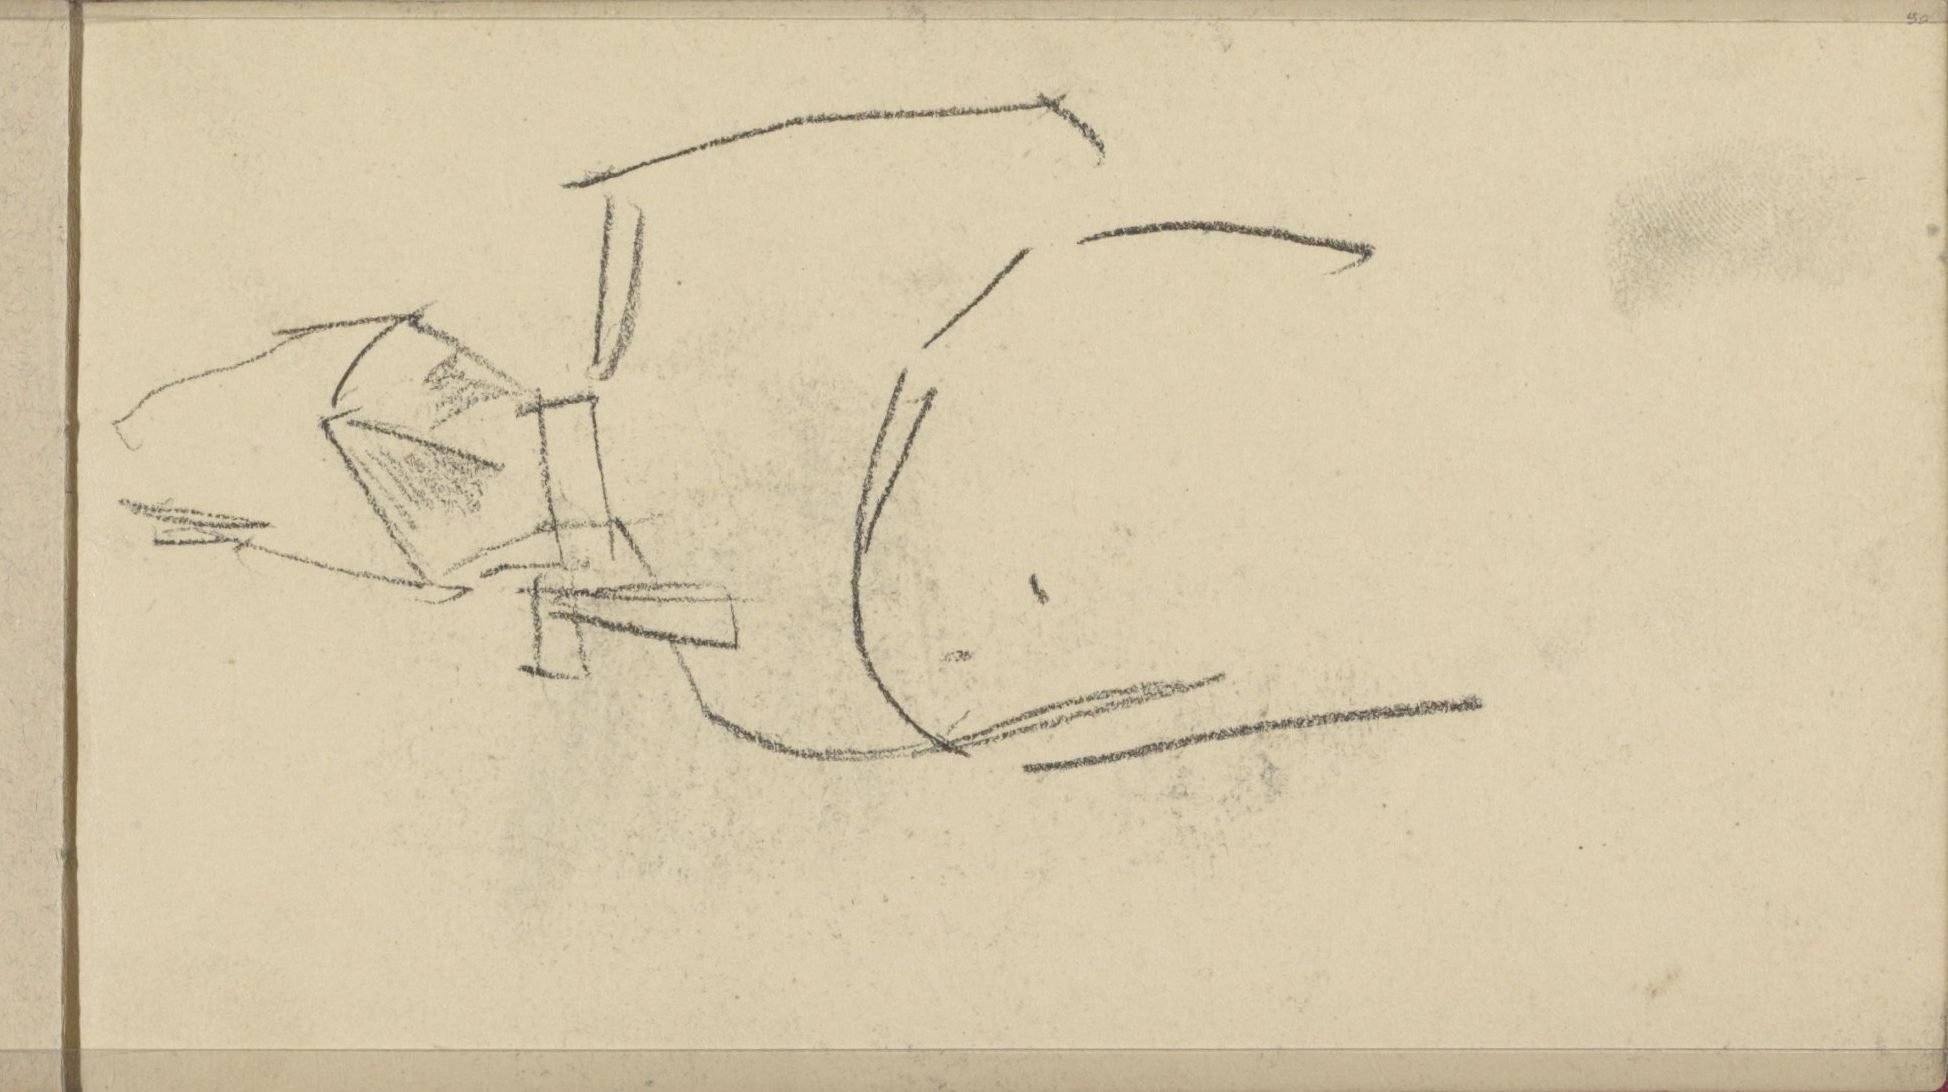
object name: sketchbook leaf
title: Figuur, op de rug gezien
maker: george hendrik breitner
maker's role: draughtsman, painter, print maker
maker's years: 1857-1923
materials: chalk, paper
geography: amsterdam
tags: sitting figure (+ back view), adult man (+ back view)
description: Mogelijk een zittende man. Pagina 50 uit een schetsboek met 32 bladen.